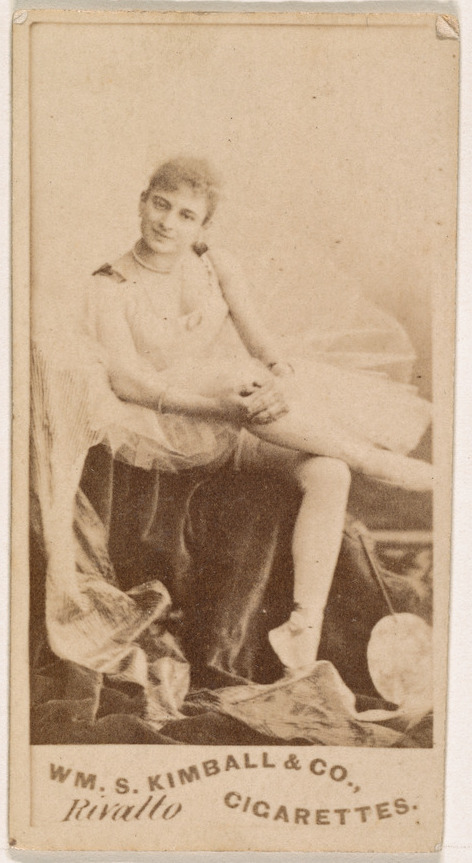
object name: photograph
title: Miss Rivalto, from the Actresses series (N203) issued by Wm. S. Kimball & Co.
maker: william s. kimball & company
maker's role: publisher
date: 1889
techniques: color lithograph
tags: portraits,women,actresses